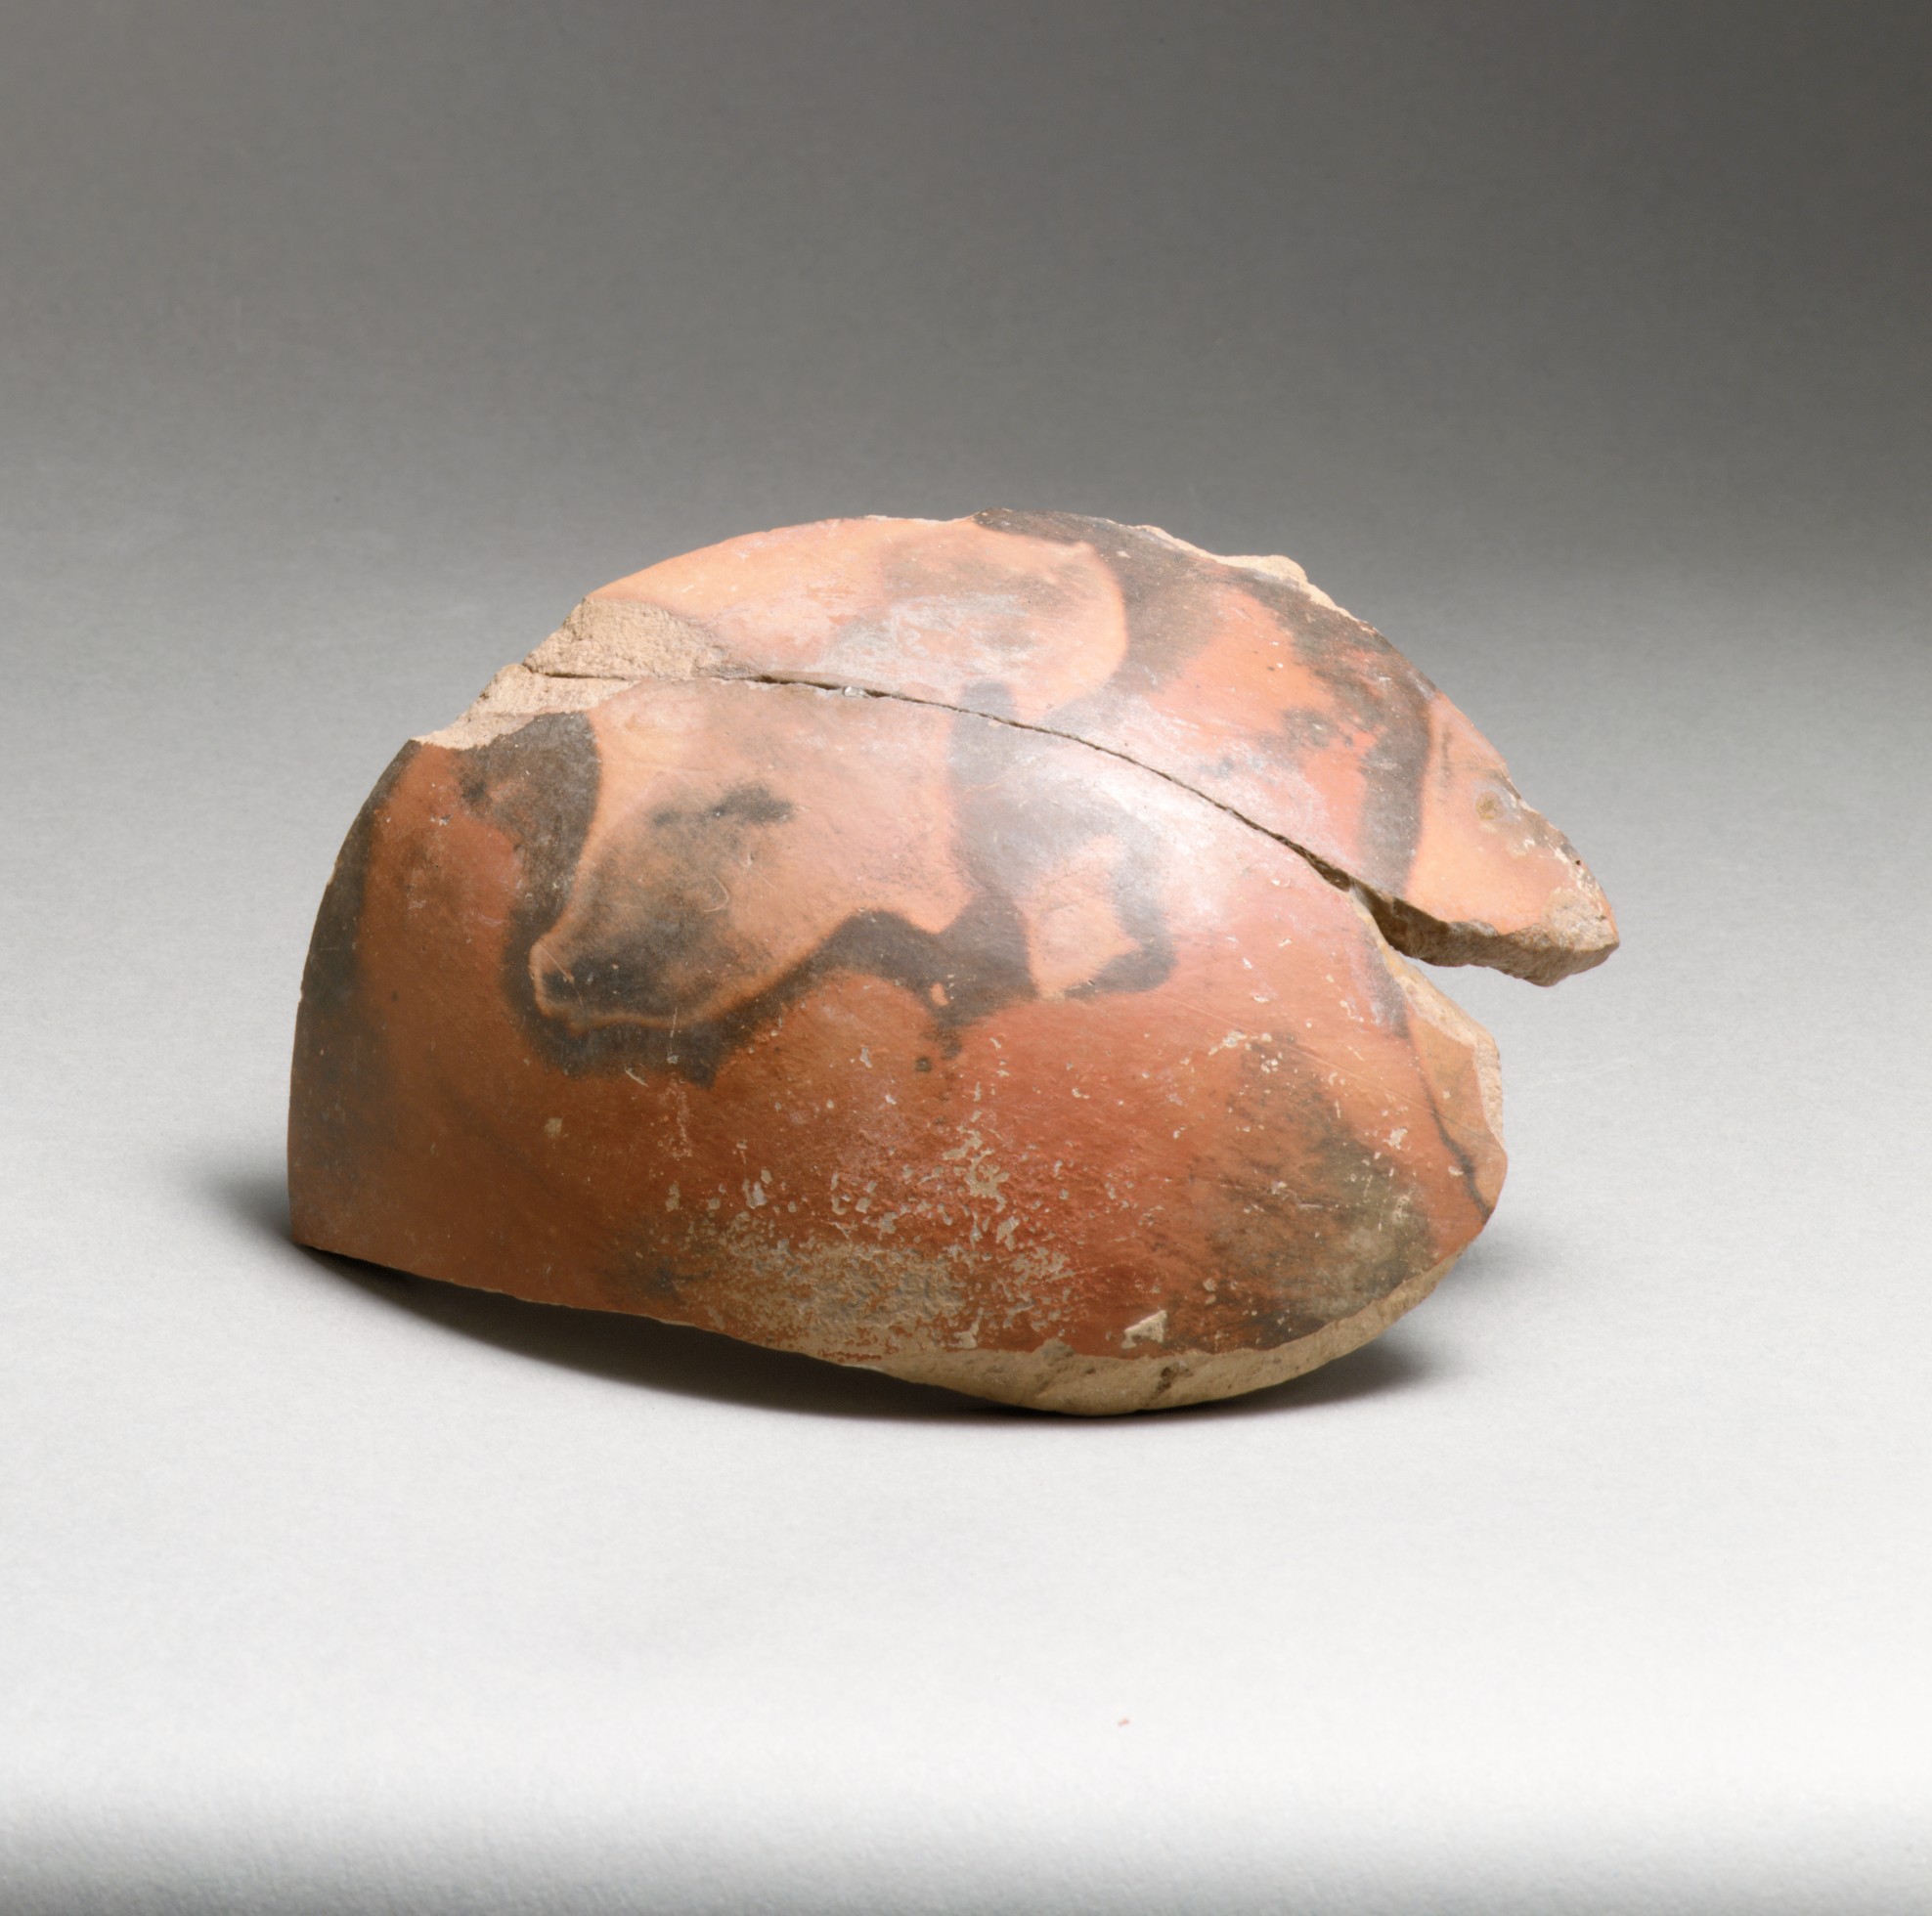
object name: vase fragment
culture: minoan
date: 2600-2000 BCE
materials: terracotta